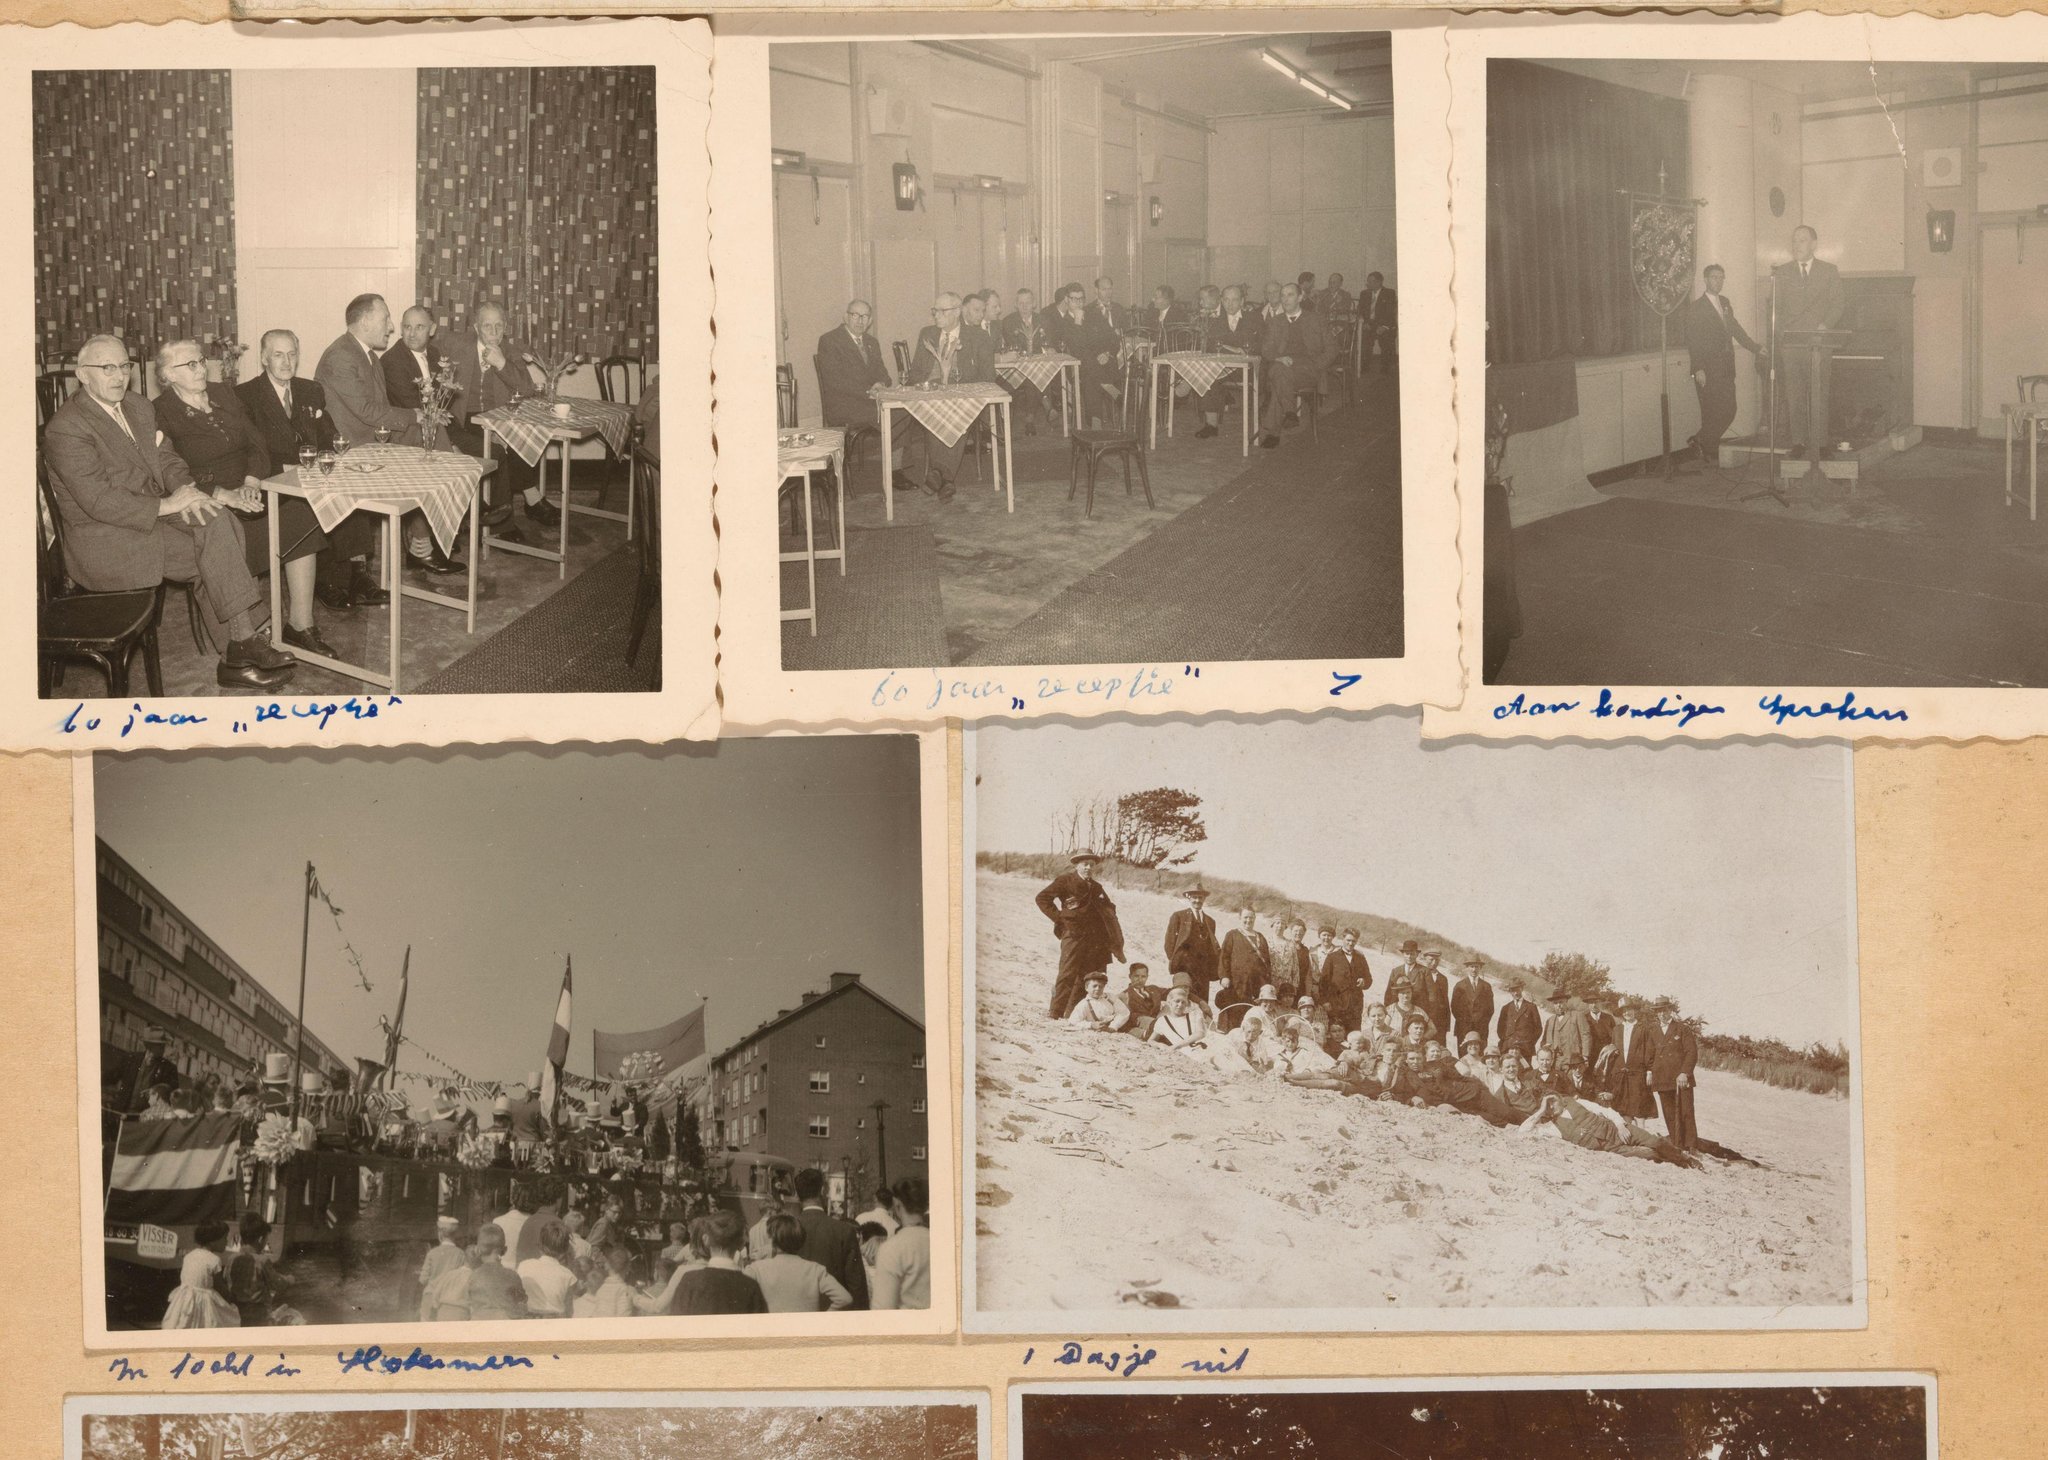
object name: photograph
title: Intocht in Slotermeer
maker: Anonymous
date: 1950-1970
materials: cardboard, photographic support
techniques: gelatin silver print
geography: geuzenveld-slotermeer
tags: amsterdam